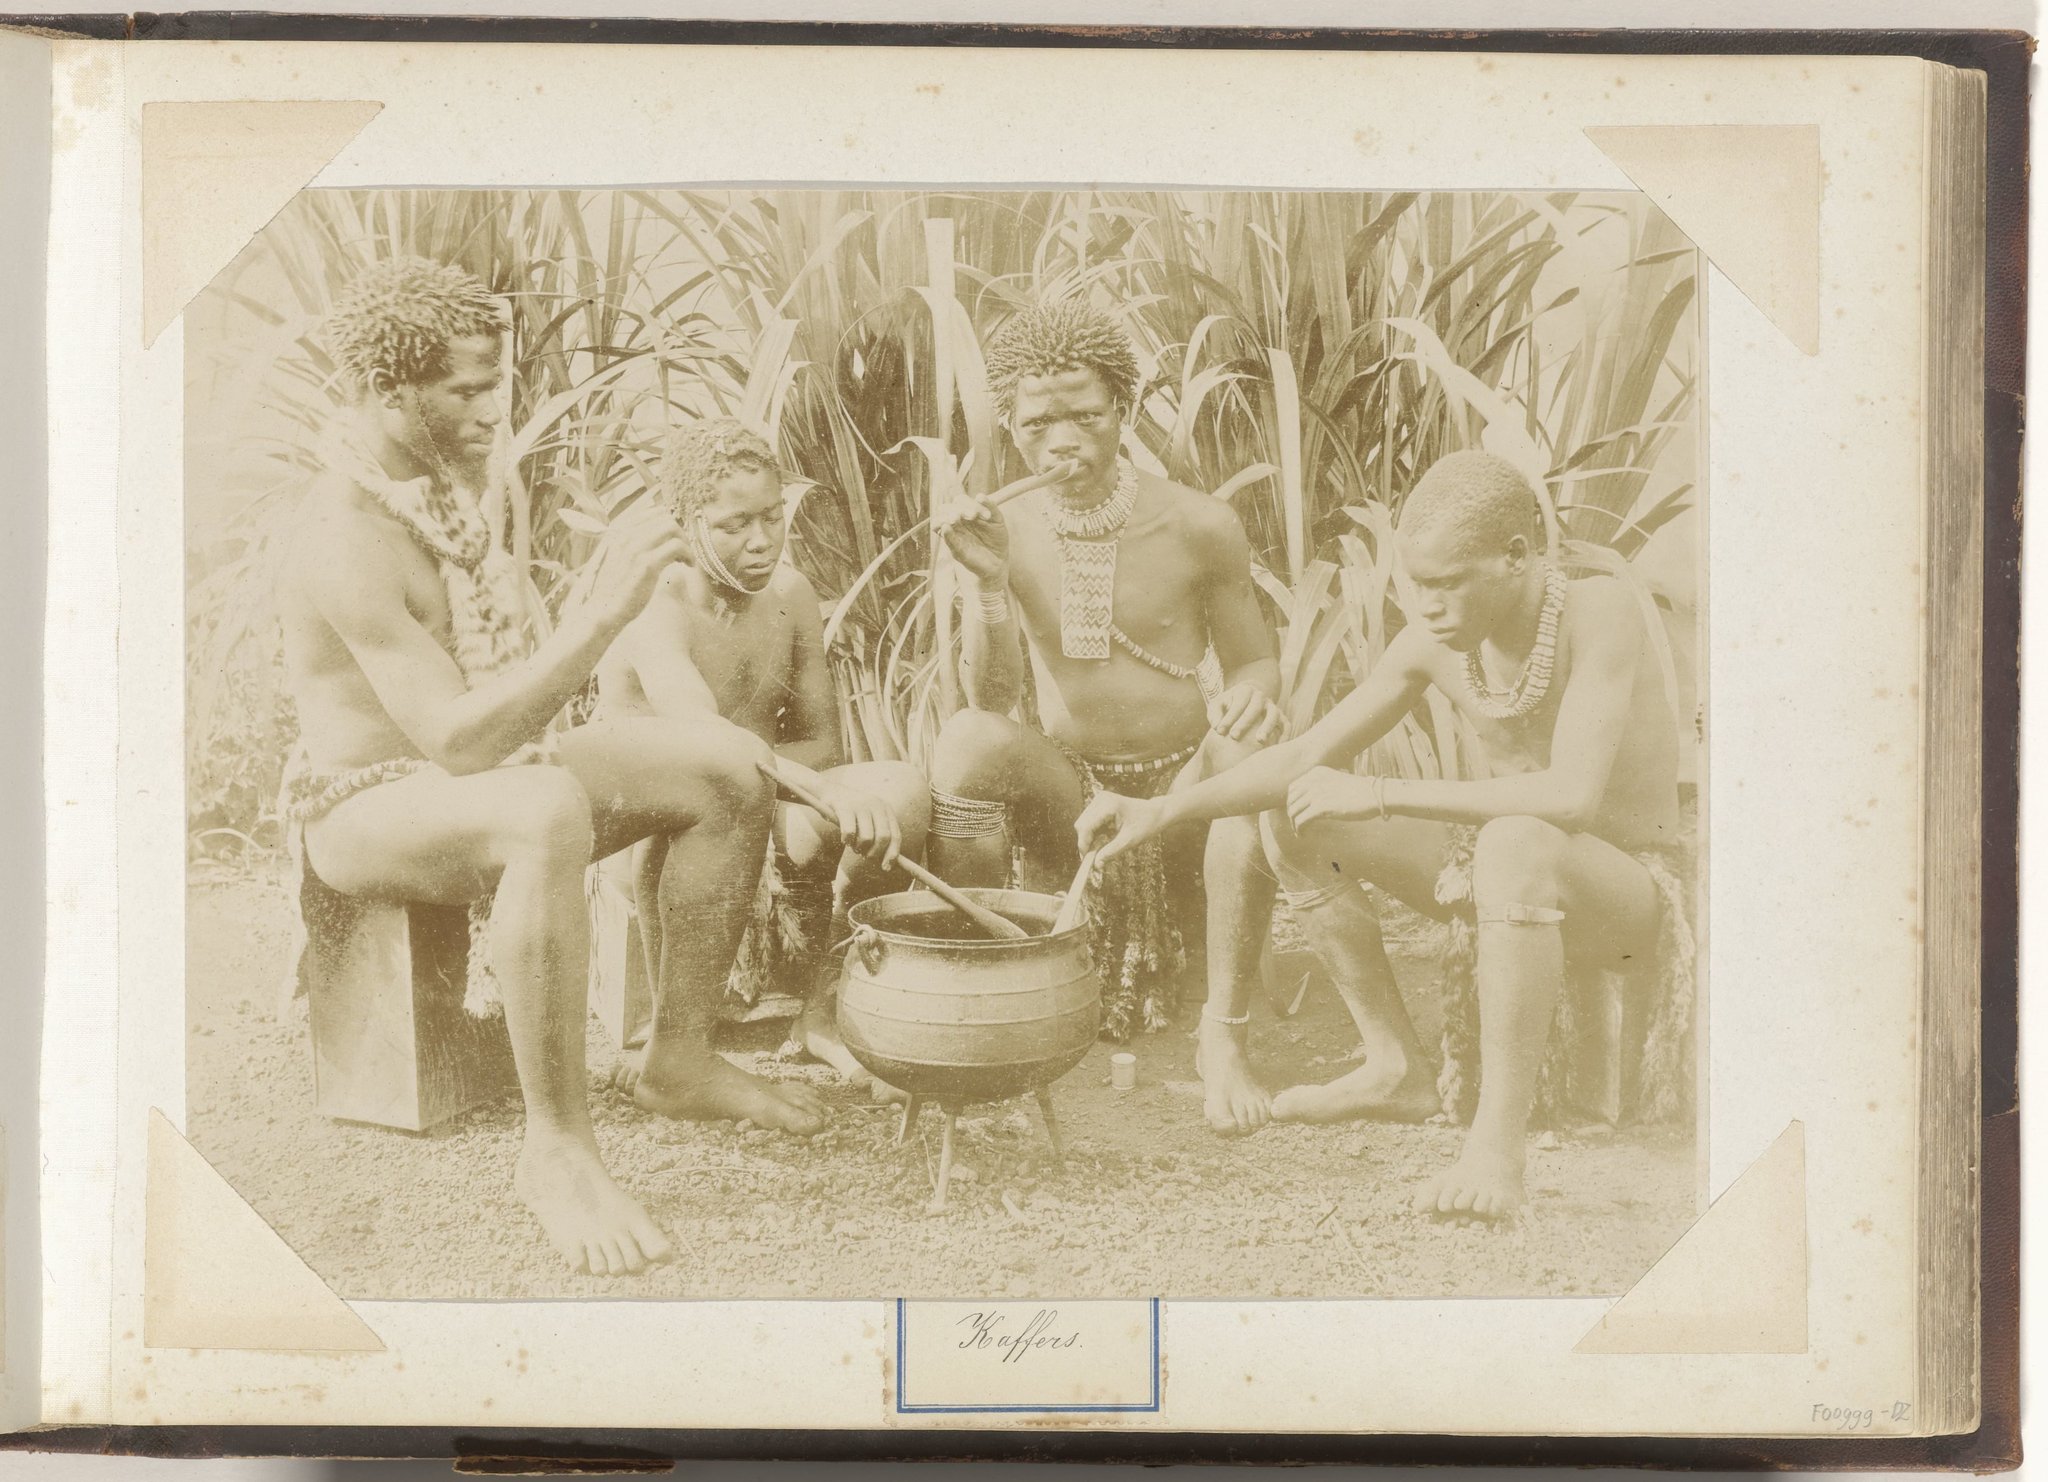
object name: photograph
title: Vier zwarte mannen zittend rond een kookpot in Zuid-Afrika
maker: Anonymous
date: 1890-1920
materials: paper, photographic support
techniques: gelatin silver print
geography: south africa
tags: africans, kitchen-utensils: pot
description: Onderdeel van Album met 191 foto's van een reis naar en door Zuid-Afrika.